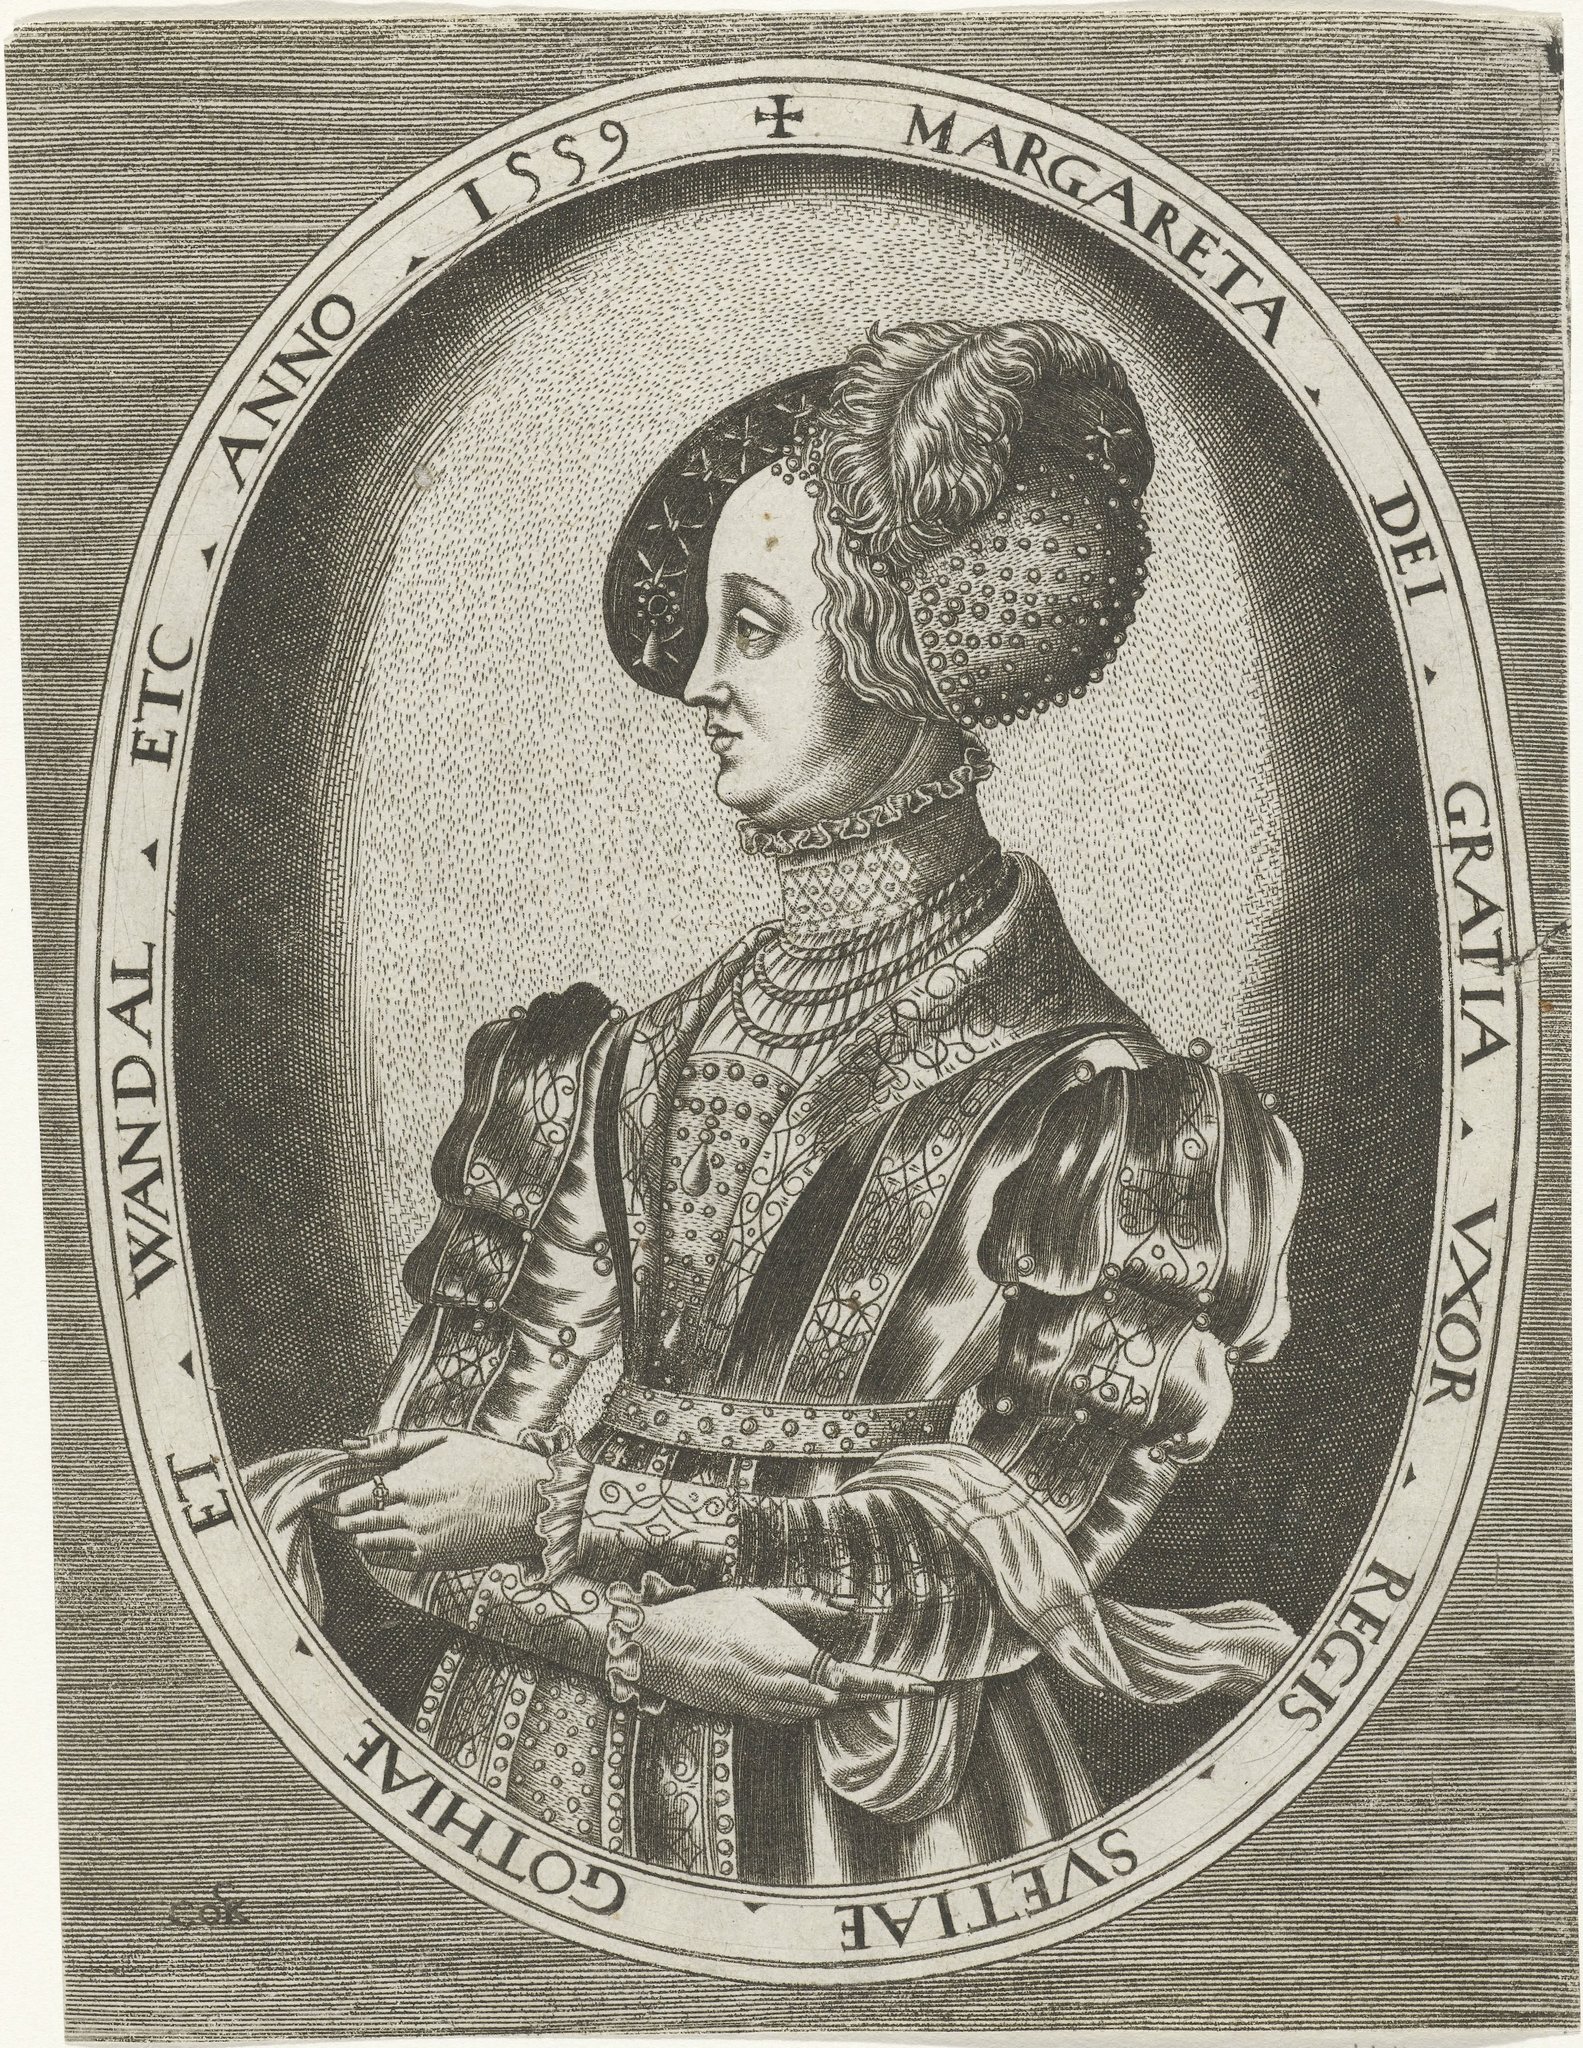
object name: print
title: Portret van koningin Margaretha Leijonhufvud van Zweden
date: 1559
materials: paper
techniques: engraving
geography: antwerp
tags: margaretha leijonhufvud (koningin van zweden)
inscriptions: collector's mark: Lugt 2228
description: Portret van Margaretha Leijonhufvud, koningin van Zweden, ten halven lijve naar links in een ovale lijst met randschrift in het Latijn.